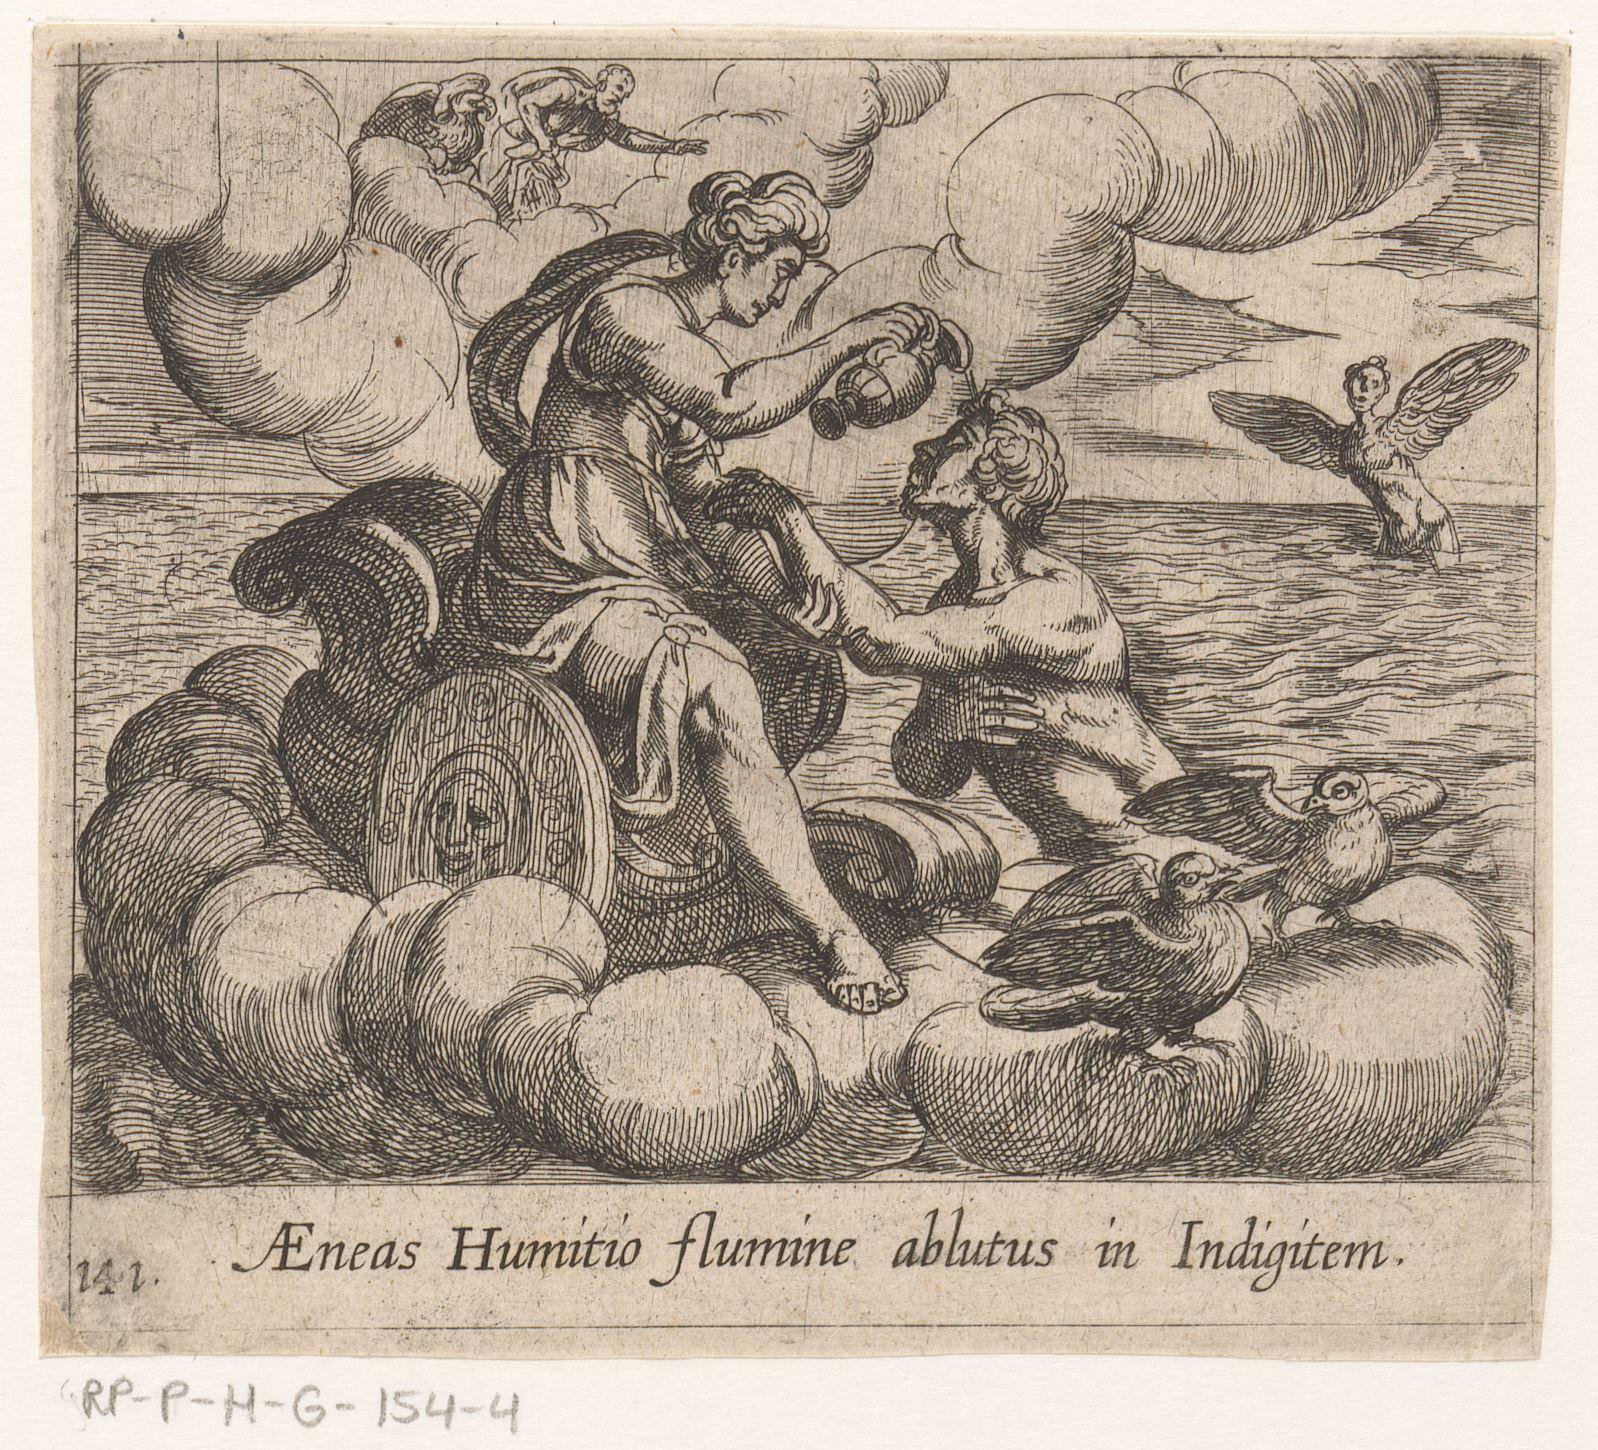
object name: print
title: Metamorphoseon sive transformationum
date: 1606-1638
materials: paper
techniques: etching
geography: amsterdam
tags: venus sprinkles and anoints aeneas' body with perfume and ambrosia, (story of) aeneas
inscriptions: collector's mark: ‘Hinloopen’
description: Deze prent maakt deel uit van een reeks van 150 prenten (+ titelprent) met voorstellingen van de Metamorfosen van Ovidius.